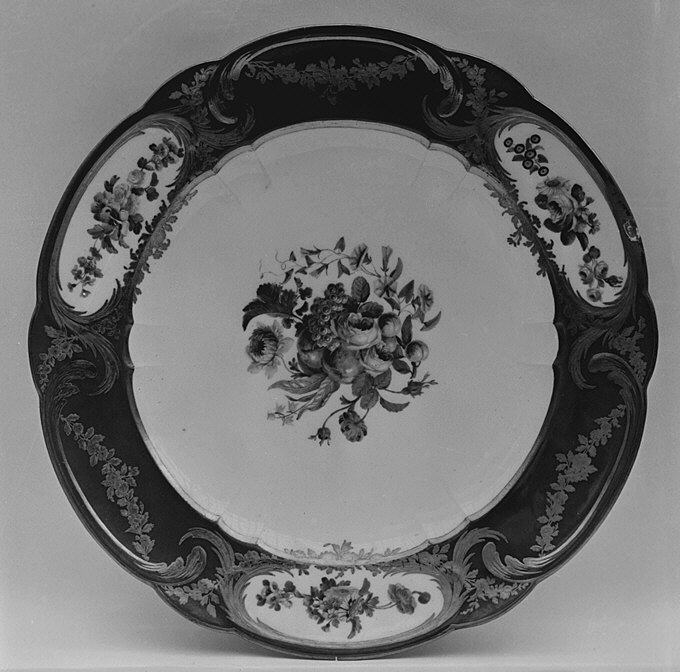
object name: plate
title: Plate (assiette à palmes) (1 of 102) (part of a service)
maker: sèvres manufactory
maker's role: manufactory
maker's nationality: french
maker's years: 1740-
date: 1786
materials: soft paste porcelain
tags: flowers